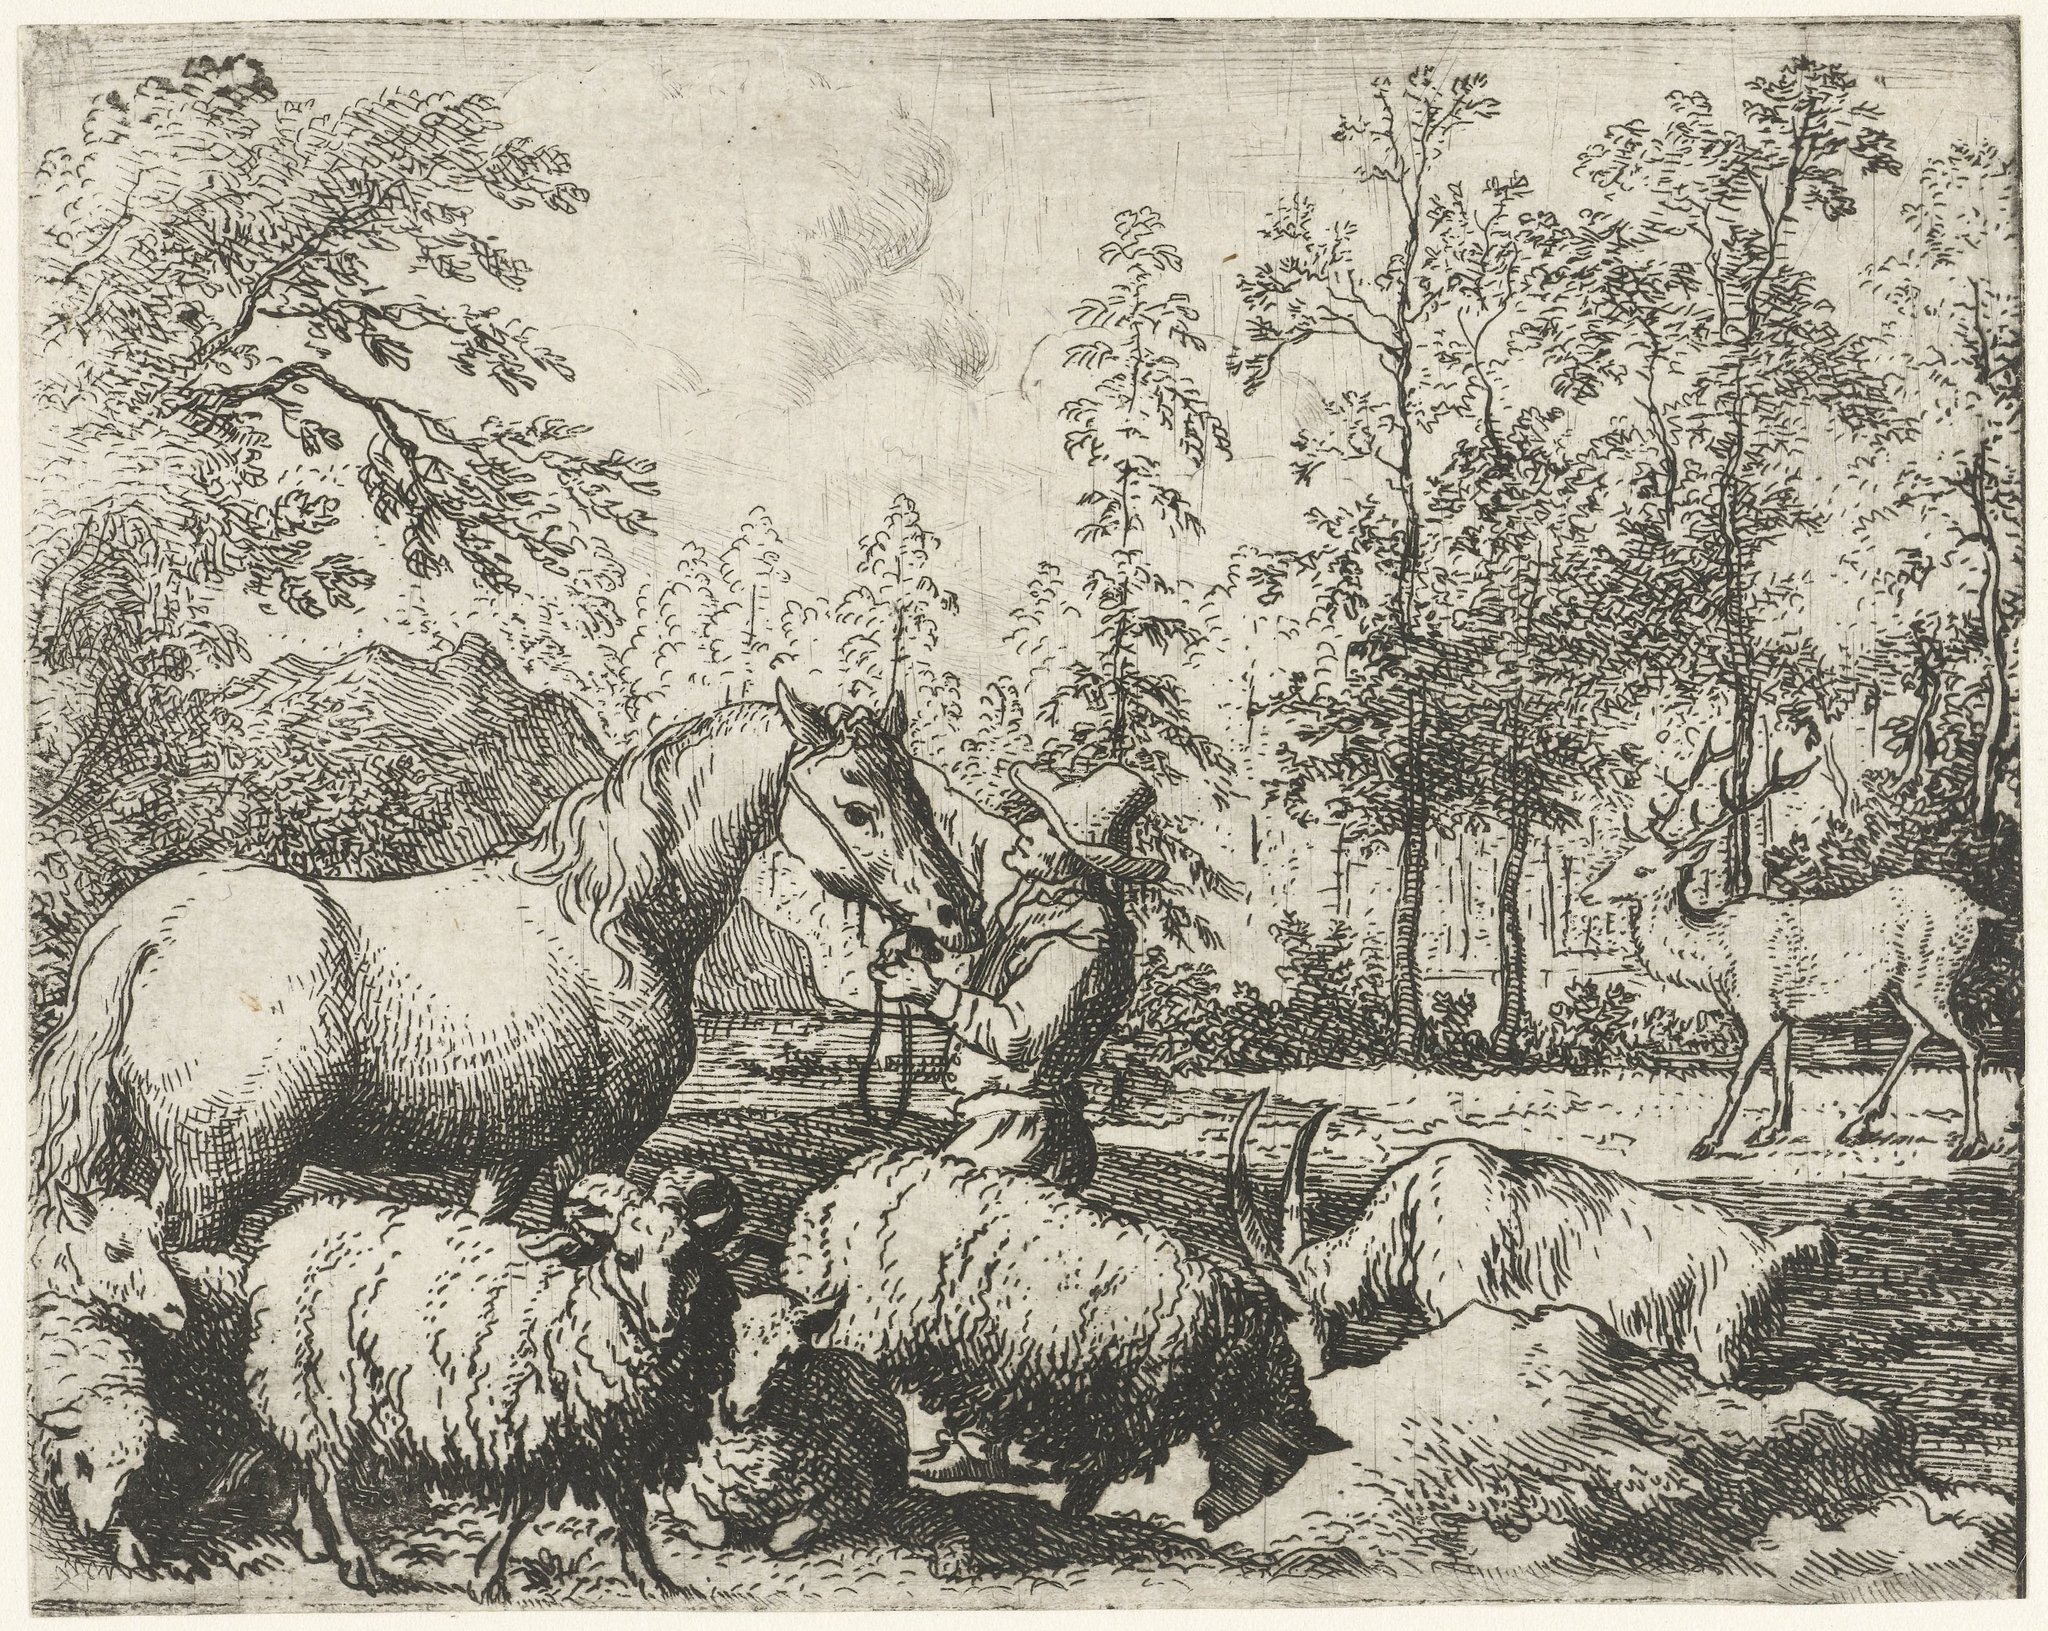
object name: print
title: Reinaert de vos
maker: allaert van everdingen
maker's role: draughtsman, painter, print maker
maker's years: 1621-1675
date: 1665-1675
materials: paper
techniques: etching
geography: netherlands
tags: horse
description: Een man houdt een paard aan de teugels vast. Op de voorgrond schapen en een bok, op de achtergrond een hert.